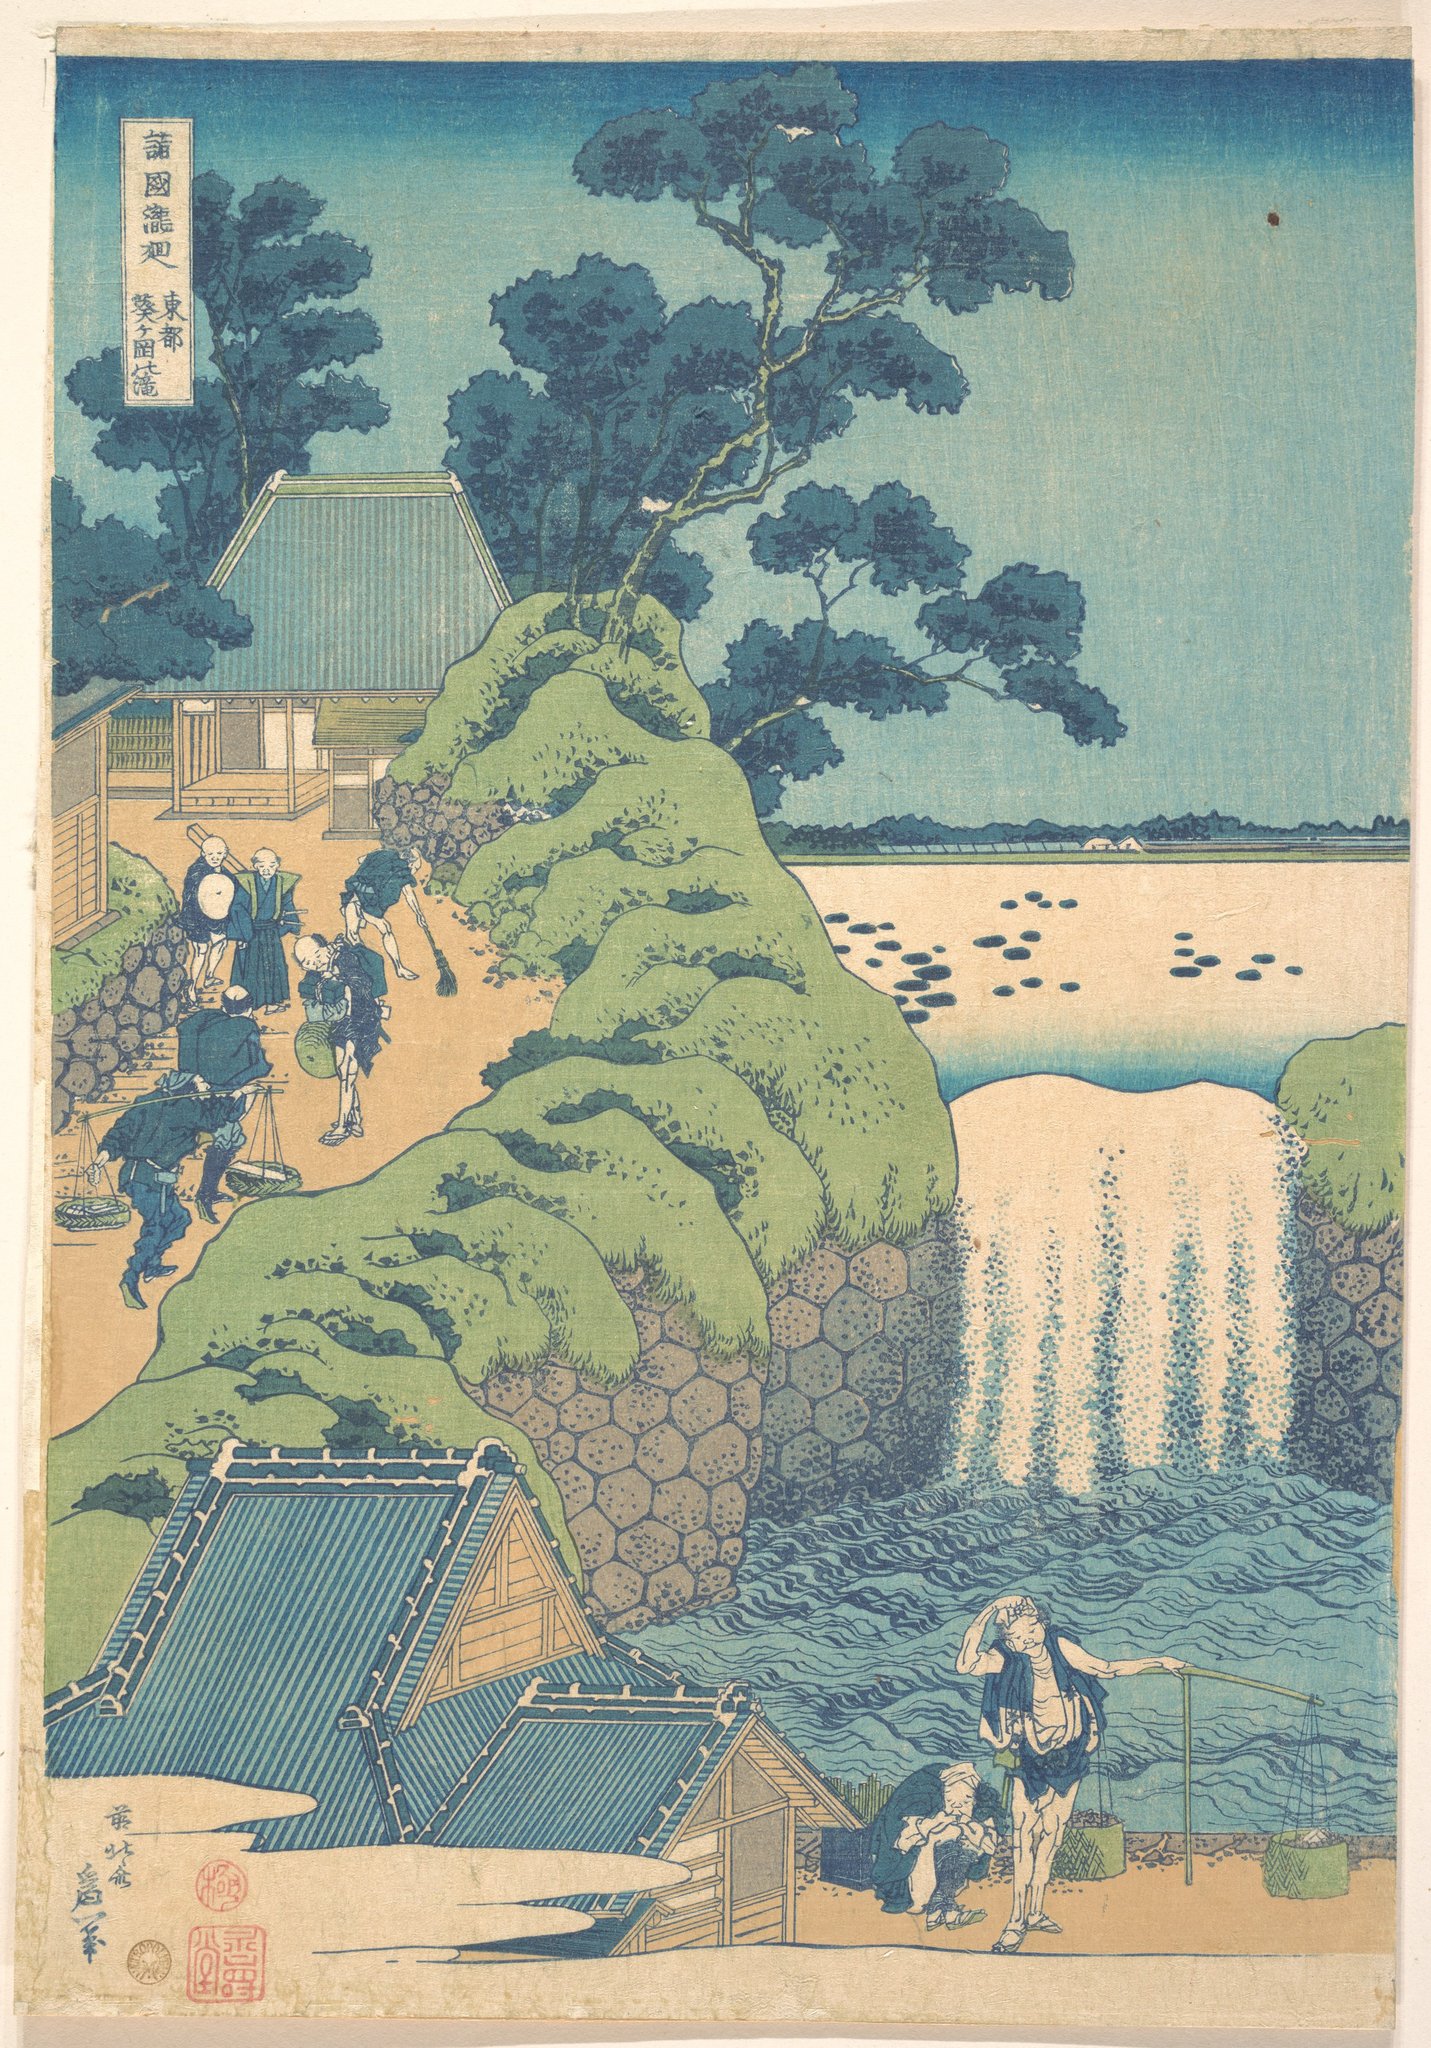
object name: print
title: Fall of Aoiga Oka, Yedo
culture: japanese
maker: katsushika hokusai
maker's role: artist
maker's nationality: japanese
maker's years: 1760-1849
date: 1827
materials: ink, paper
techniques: woodblock print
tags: houses,men,waterfalls,trees